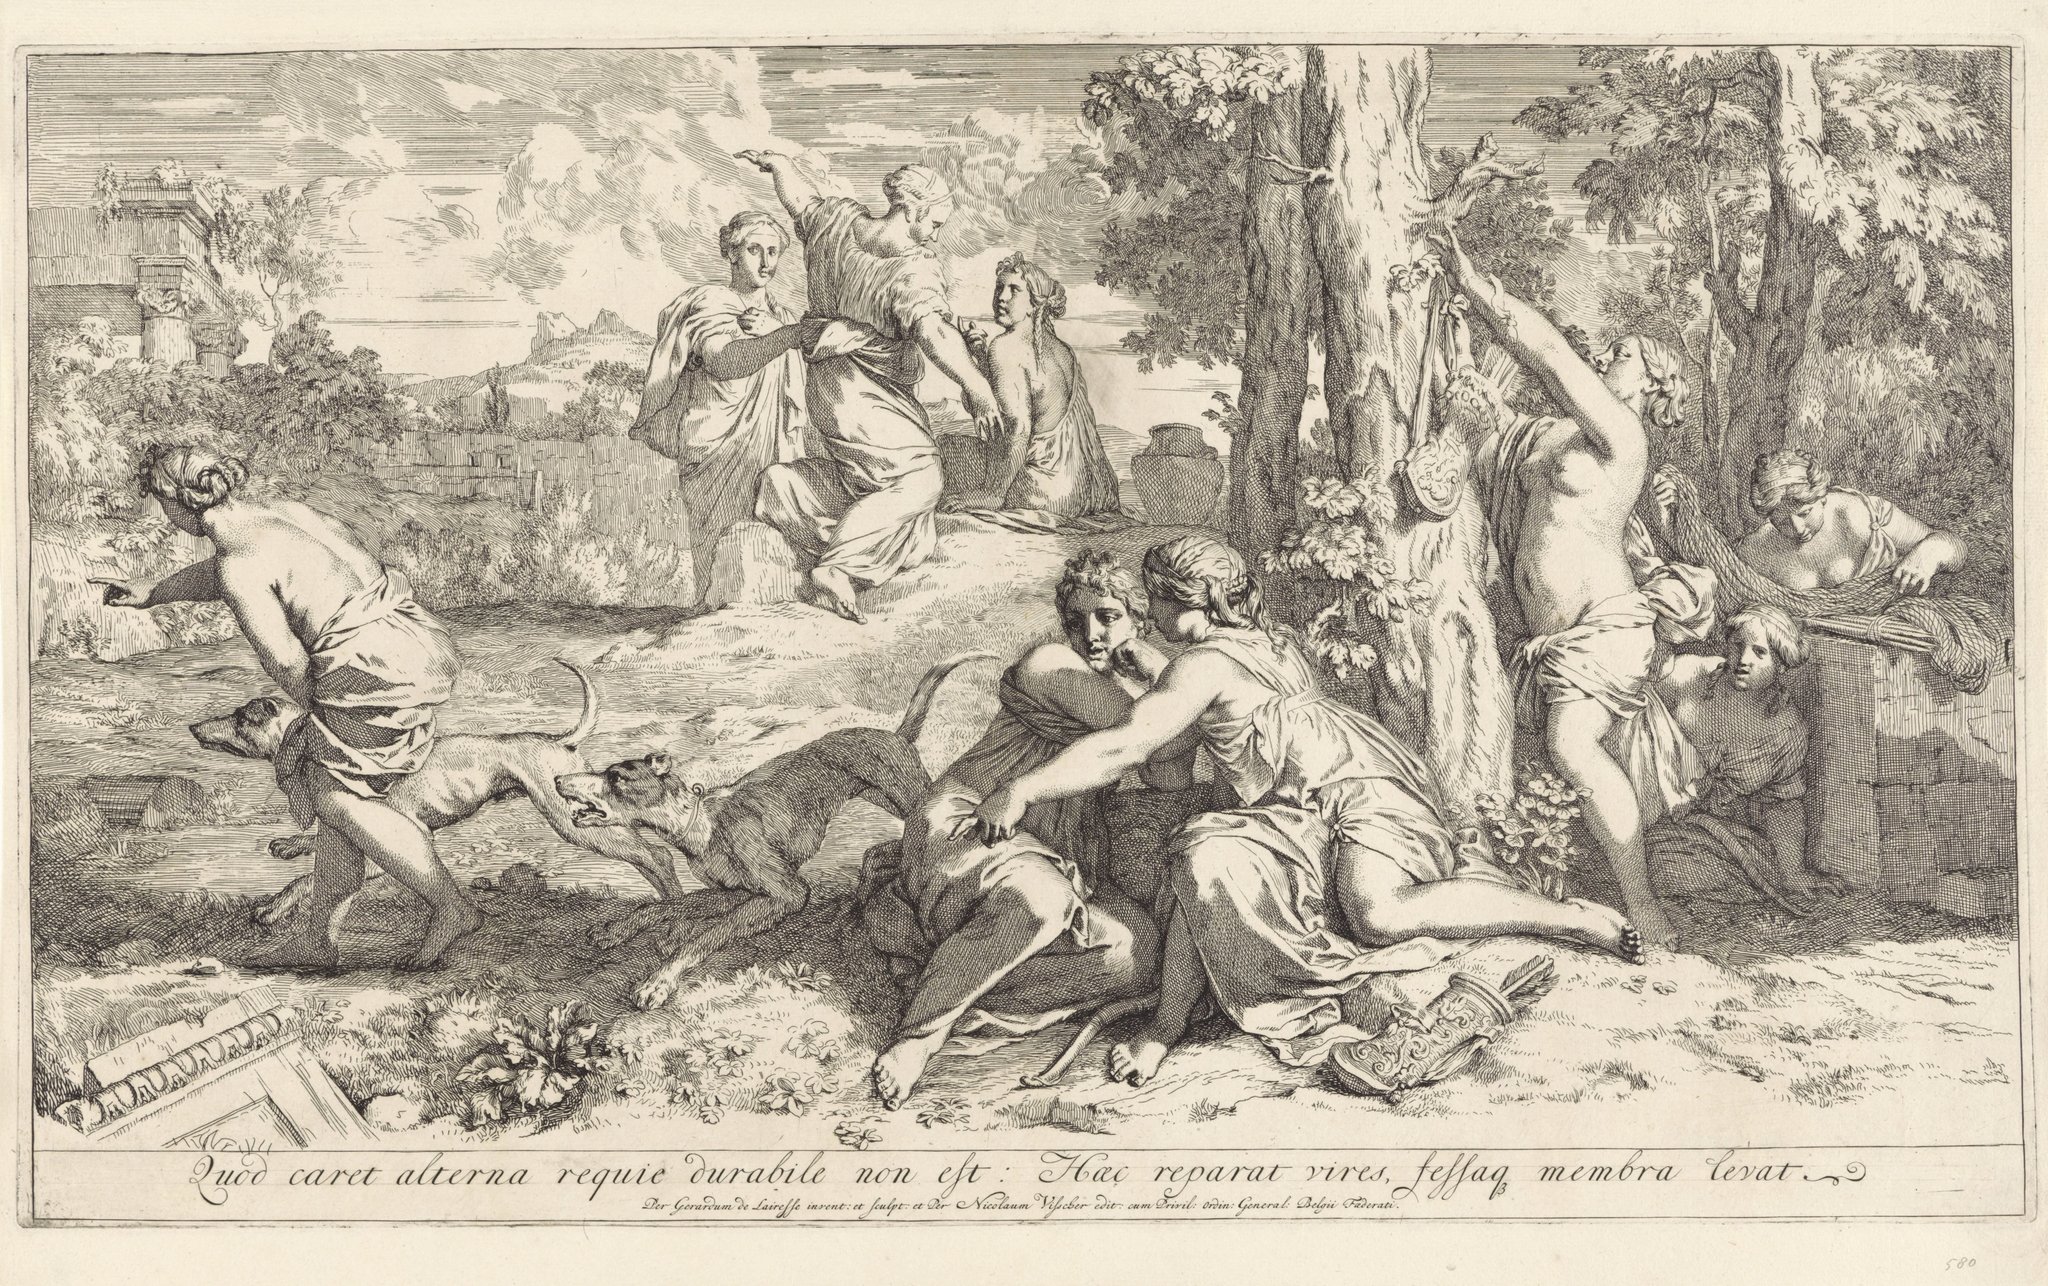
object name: print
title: Quod caret alterna requie durabile non est: Haec reparat vires, fessaque membra levat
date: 1685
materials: paper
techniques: etching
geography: amsterdam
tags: diana hunting with her nymphs (+ variant), landscape with ruins - ii - ideal landscapes, resting - bb - out of doors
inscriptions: collector's mark: Lugt 240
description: In een landschap rust een groep nimfen uit na de jacht. De jachthonden worden weggestuurd, de pijlen worden opgeborgen of weggehangen. Links zicht op een ruïne.